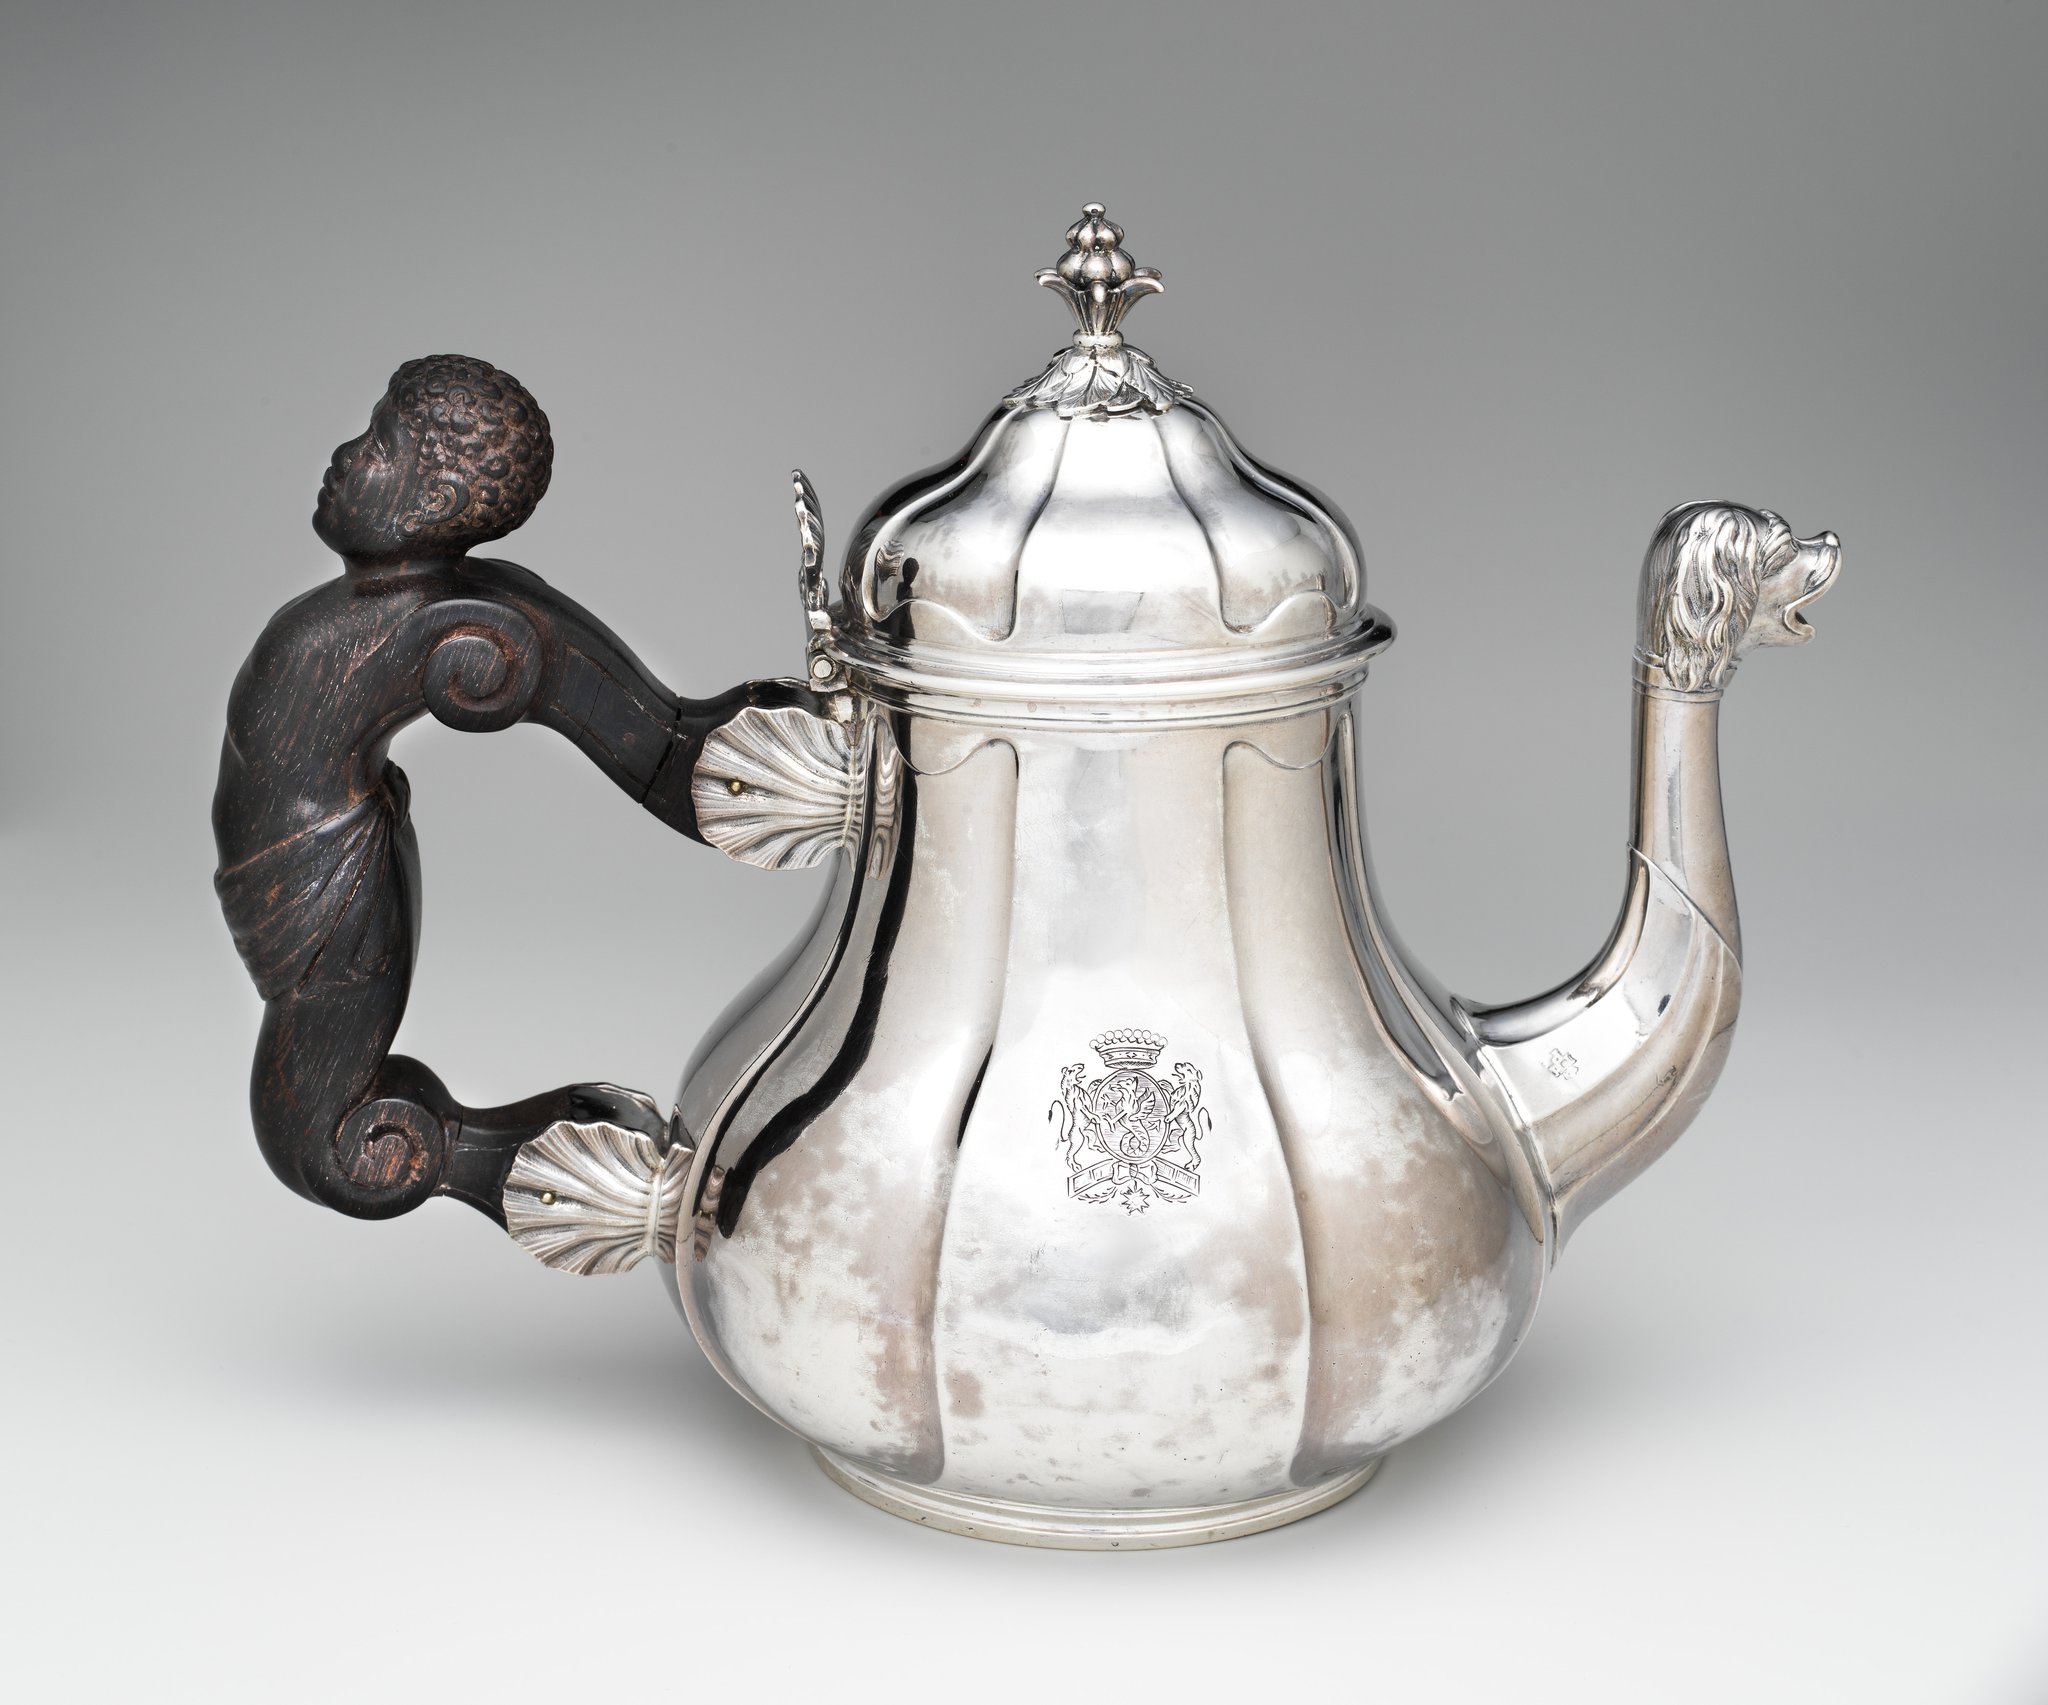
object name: teapot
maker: i.m.p.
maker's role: maker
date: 1734-1766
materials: wood, silver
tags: coat of arms